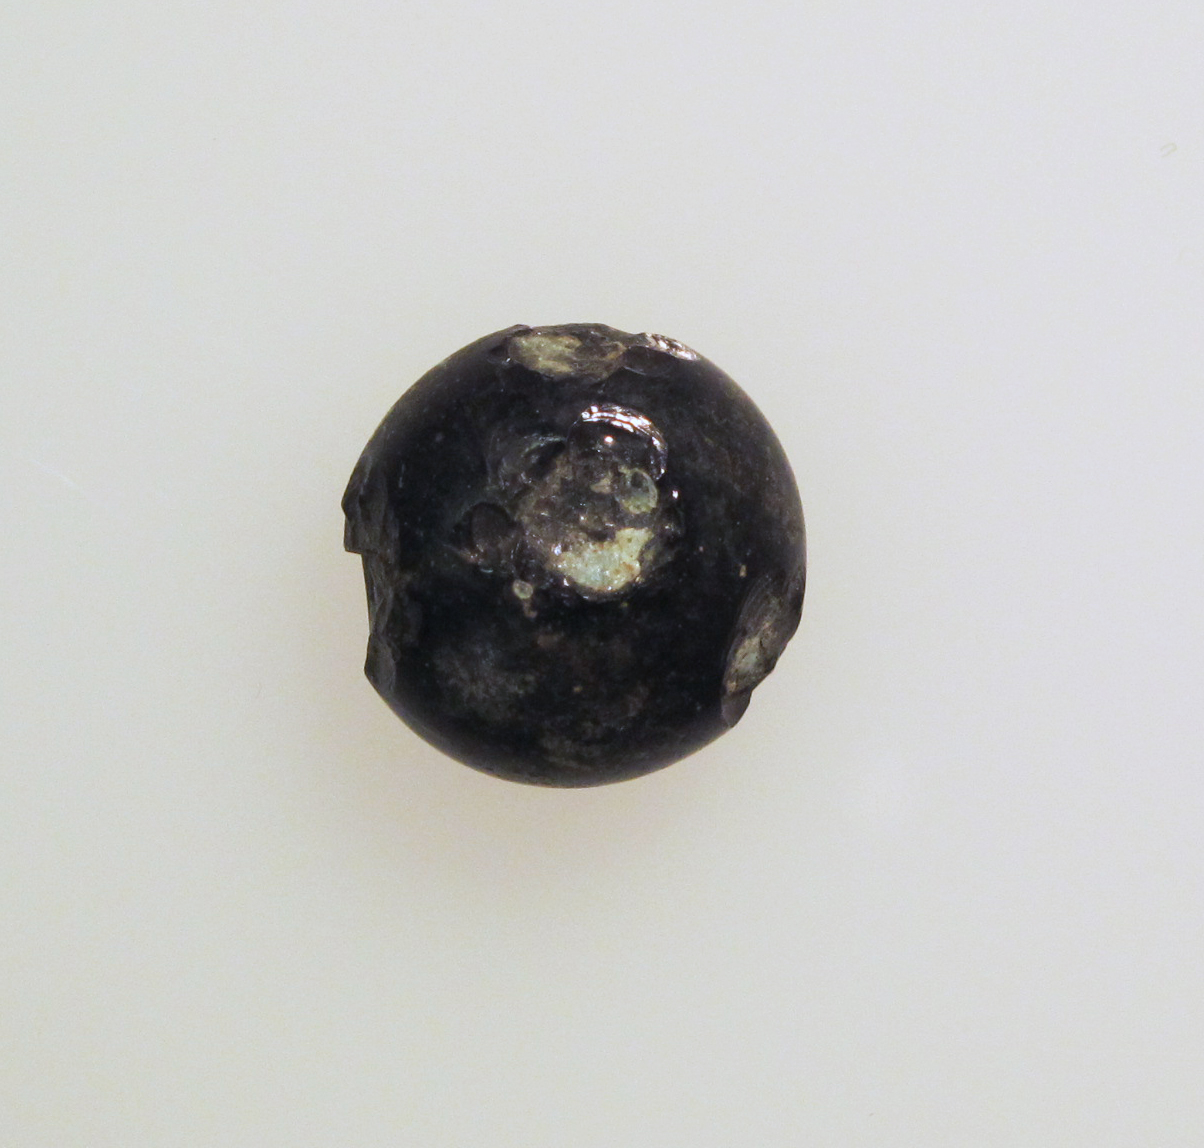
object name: pinhead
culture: roman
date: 100 BCE-500 CE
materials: glass